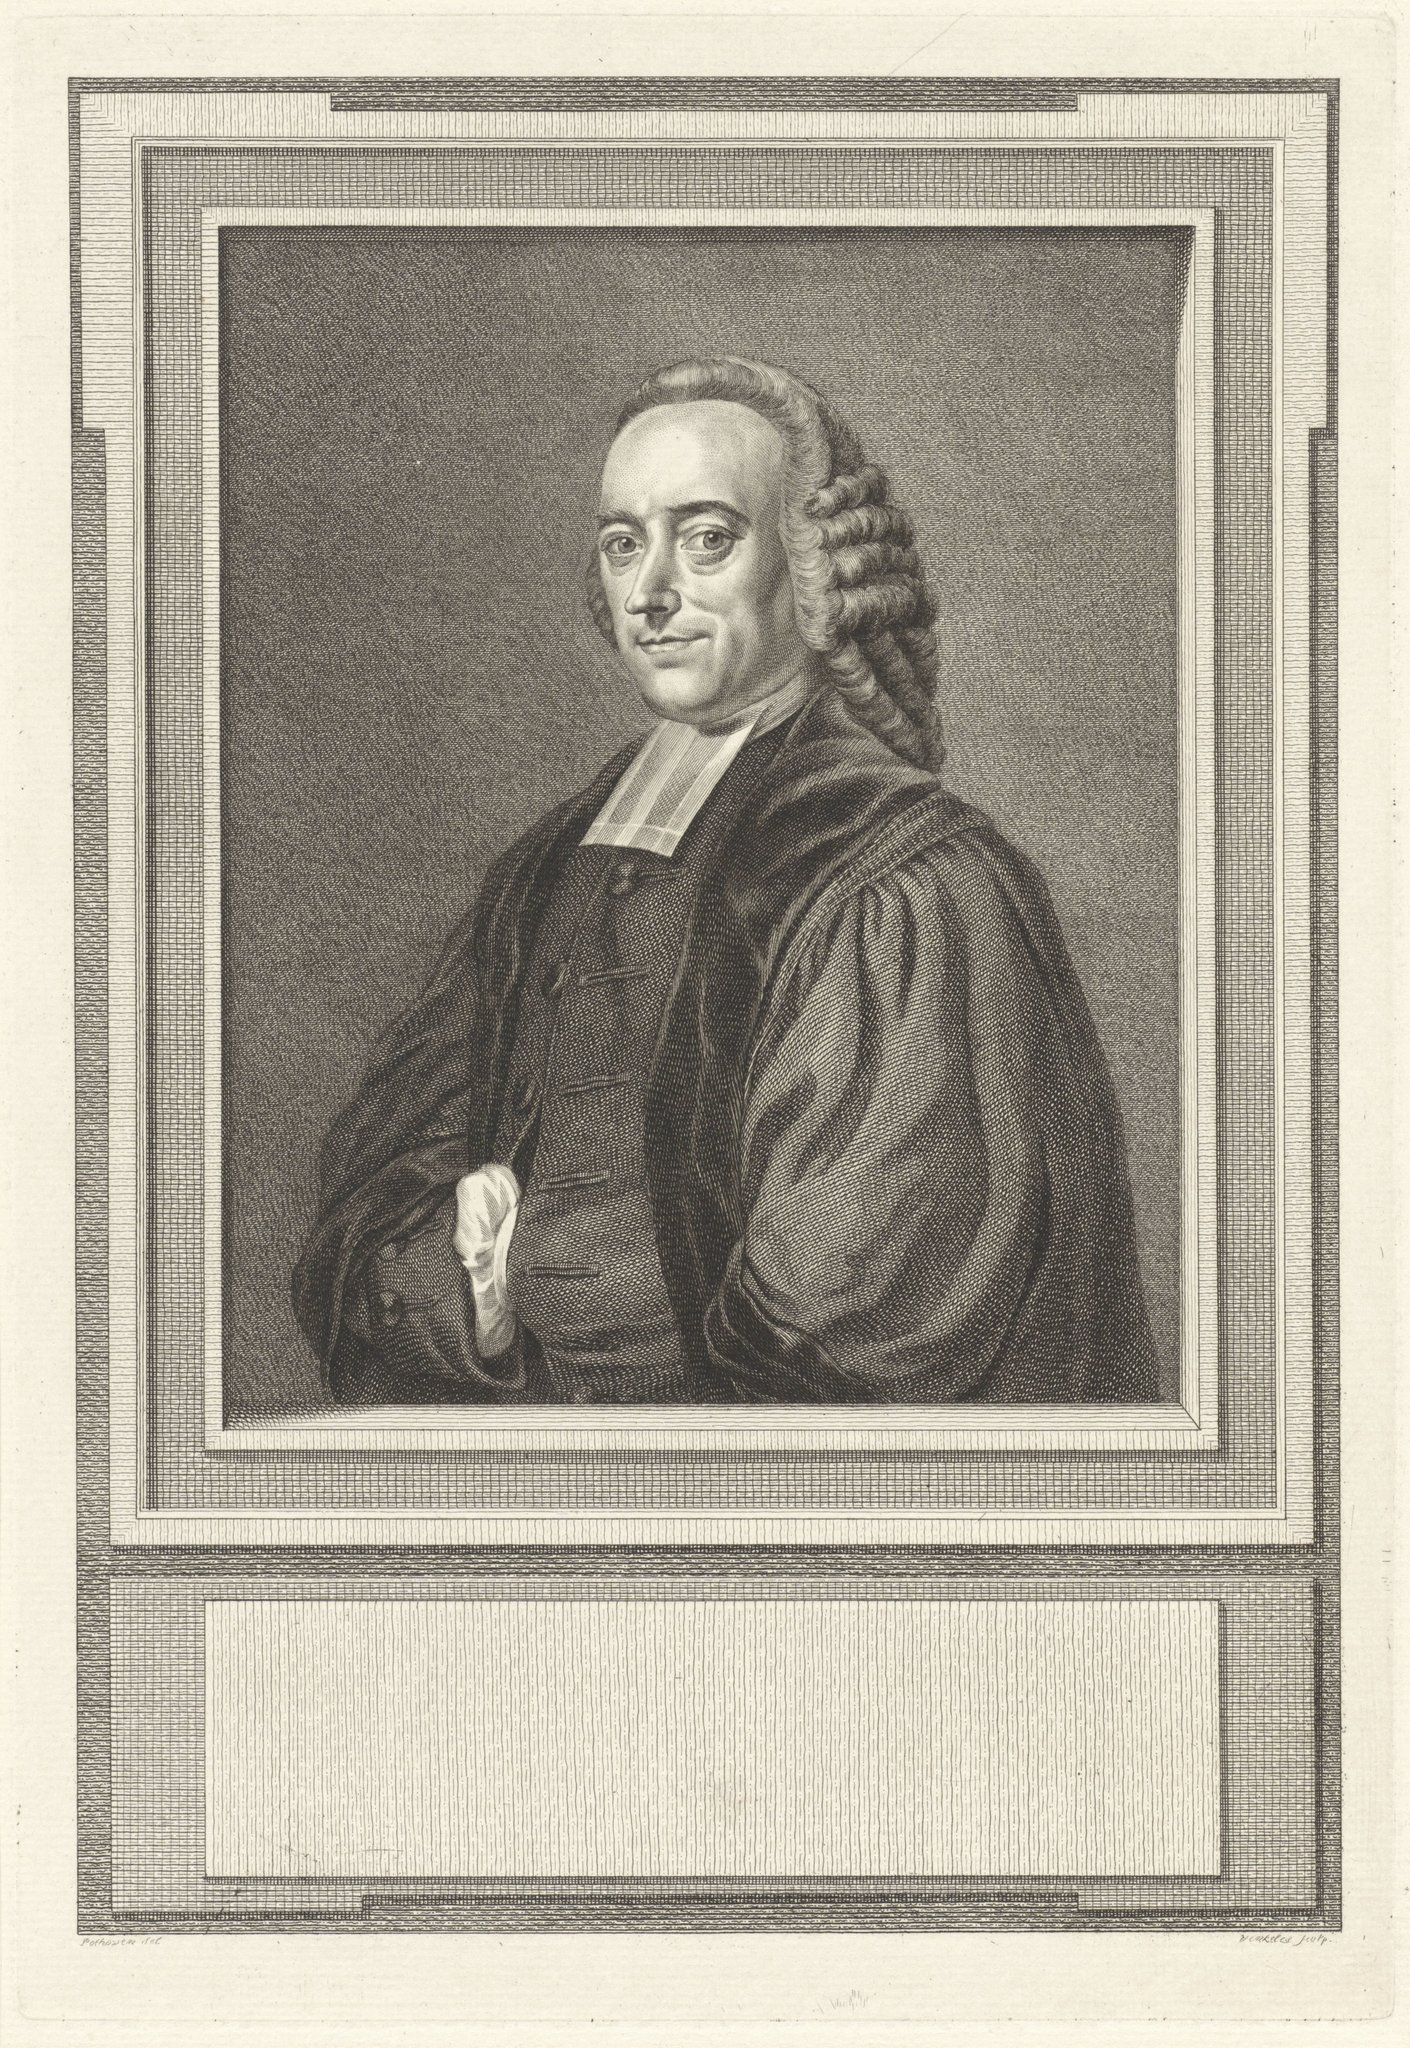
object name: print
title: Portret van de predikant Gerard Johan Nahuys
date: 1781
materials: paper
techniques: engraving, etching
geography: amsterdam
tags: utrecht, leiden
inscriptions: collector's mark: Lugt 2228